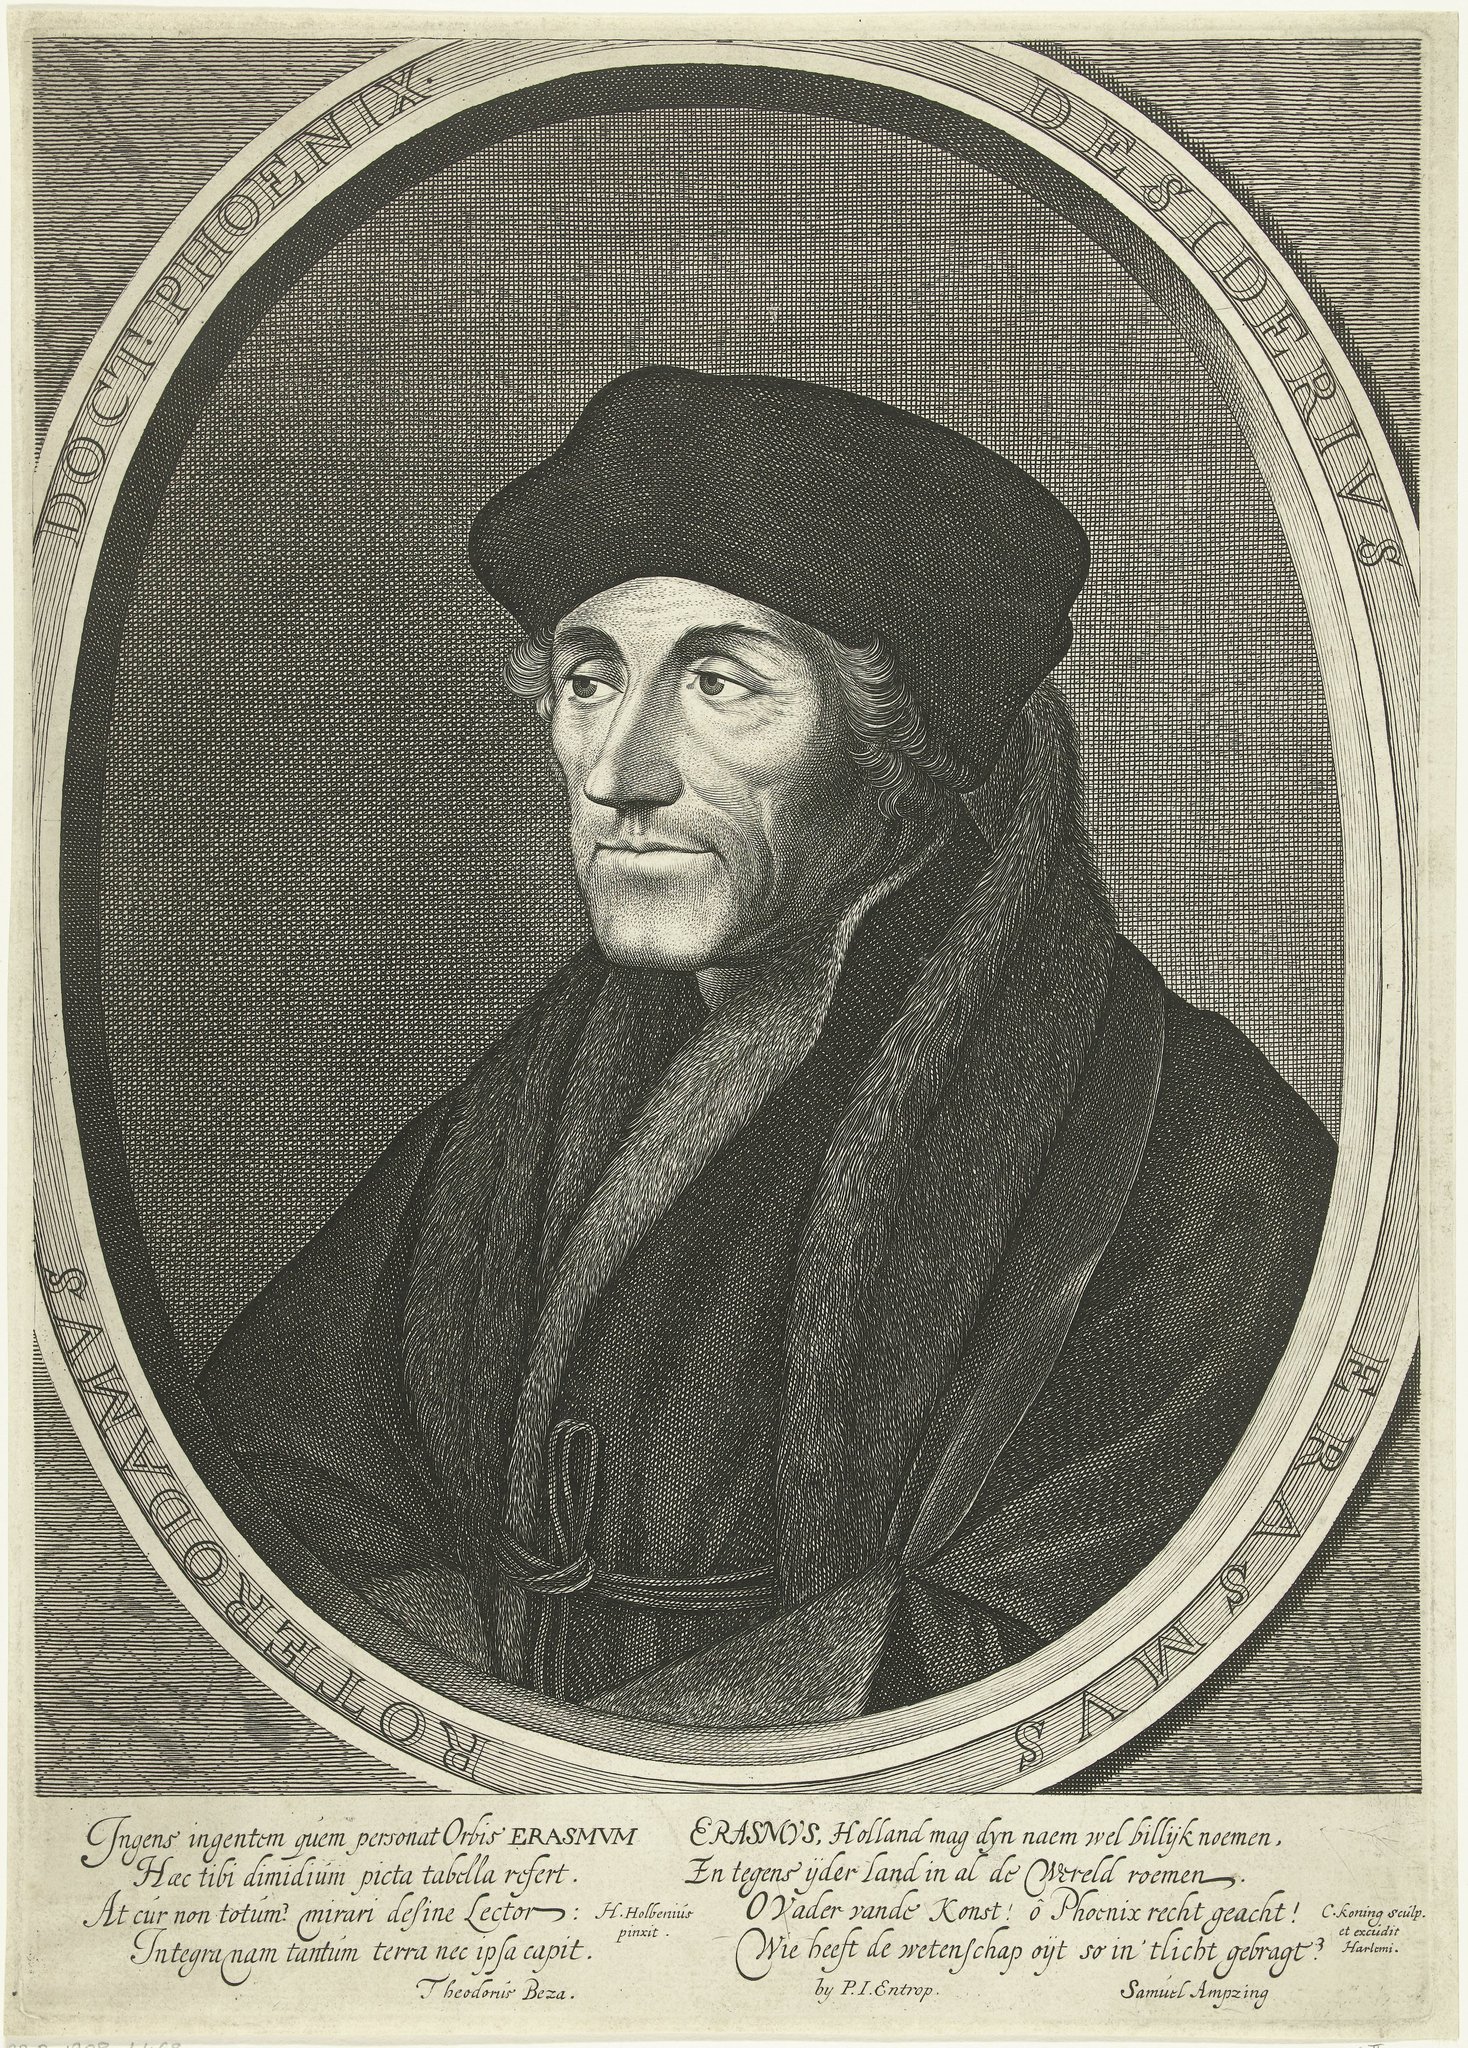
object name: print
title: Portret van Desiderius Erasmus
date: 1762-1773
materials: paper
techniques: engraving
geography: haarlem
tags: rotterdam, desiderius erasmus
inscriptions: collector's mark: Lugt 2228